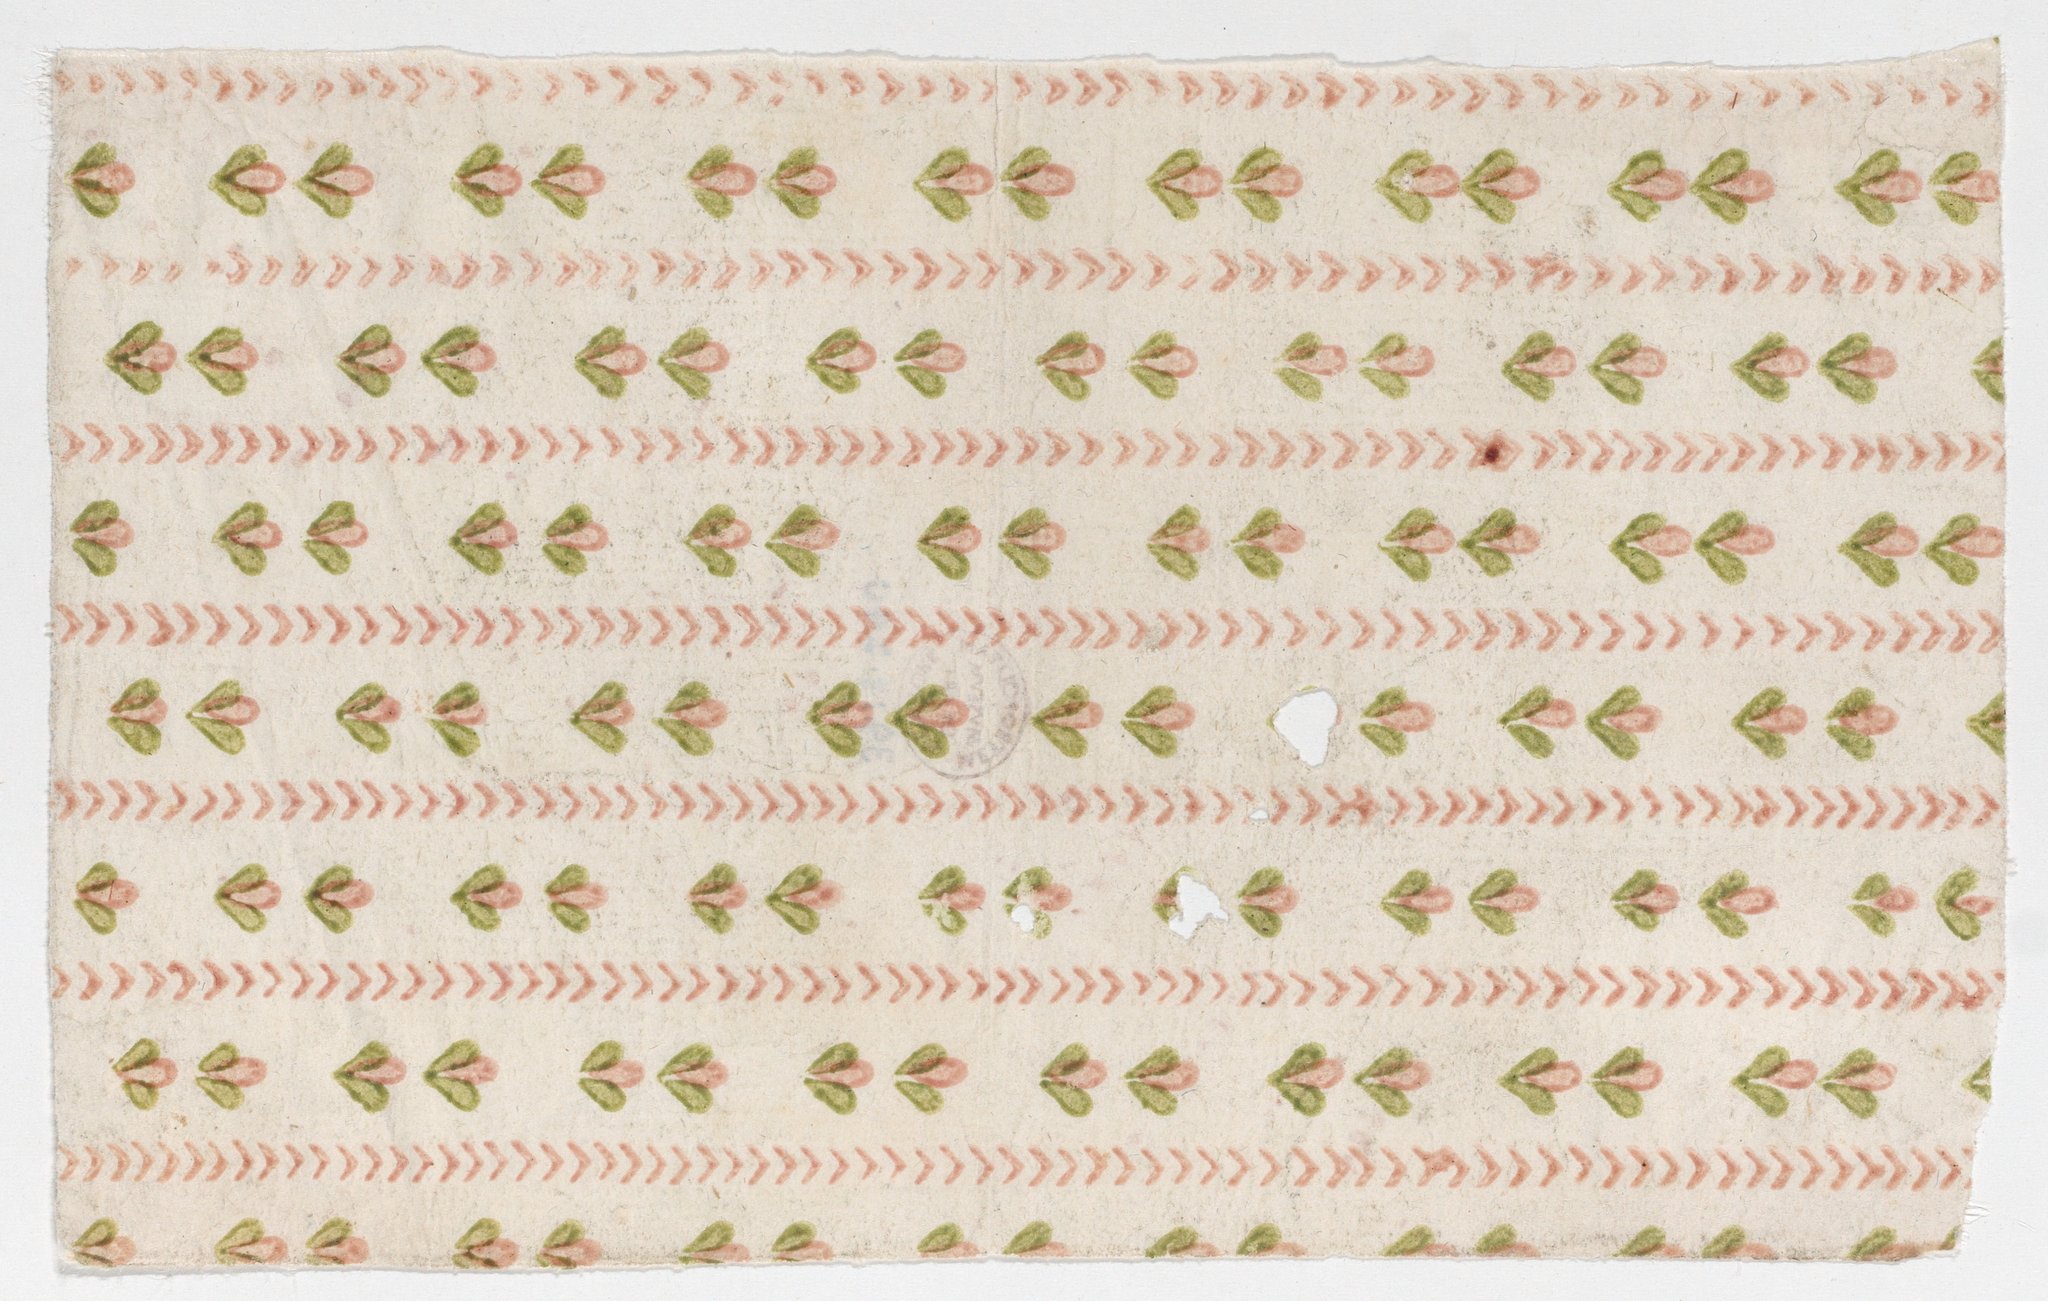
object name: print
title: Sheet with an overall floral pattern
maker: Anonymous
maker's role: artist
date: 1801-1900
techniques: relief print